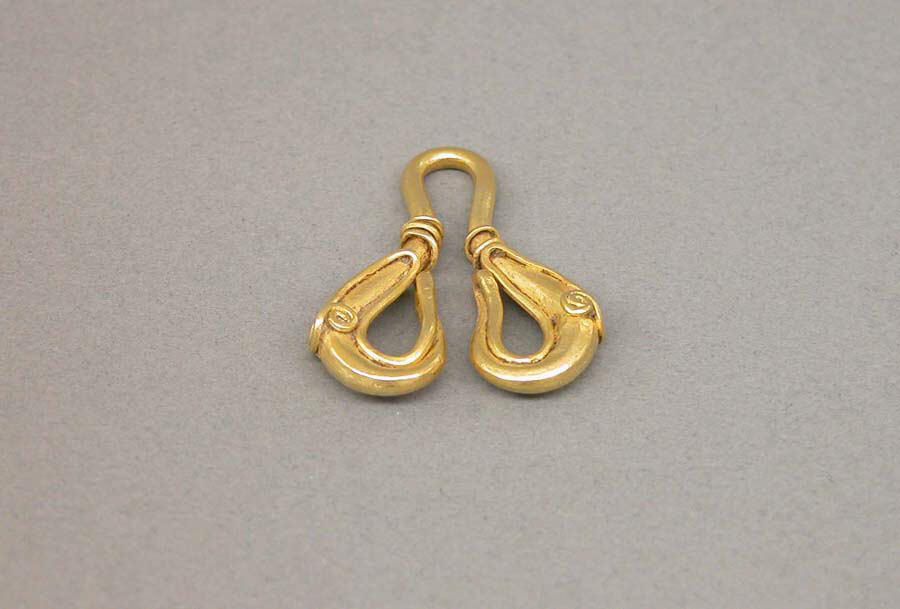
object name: pendant or ornament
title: Pendant or Ornament with Symmetrical Design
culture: indonesian, javanese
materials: gold